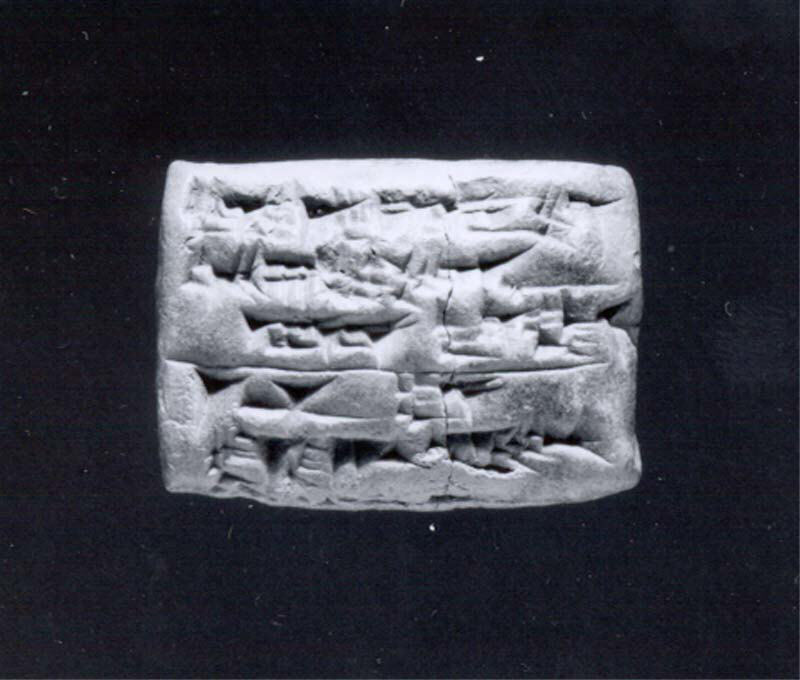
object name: cuneiform tablet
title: Cuneiform tablet: administrative memorandum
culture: assyrian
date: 1300-1201 BCE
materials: clay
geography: mesopotamia